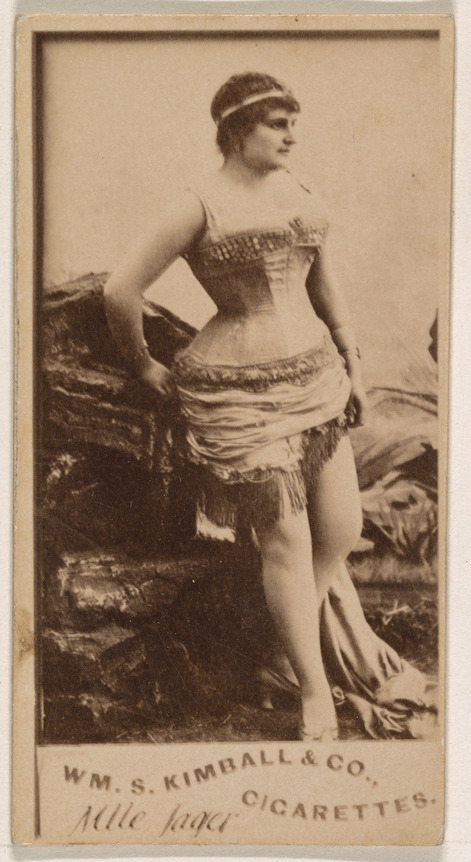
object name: photograph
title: Mlle. Jager, from the Actresses series (N203) issued by Wm. S. Kimball & Co.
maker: william s. kimball & company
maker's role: publisher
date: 1889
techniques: color lithograph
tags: profiles,women,actresses